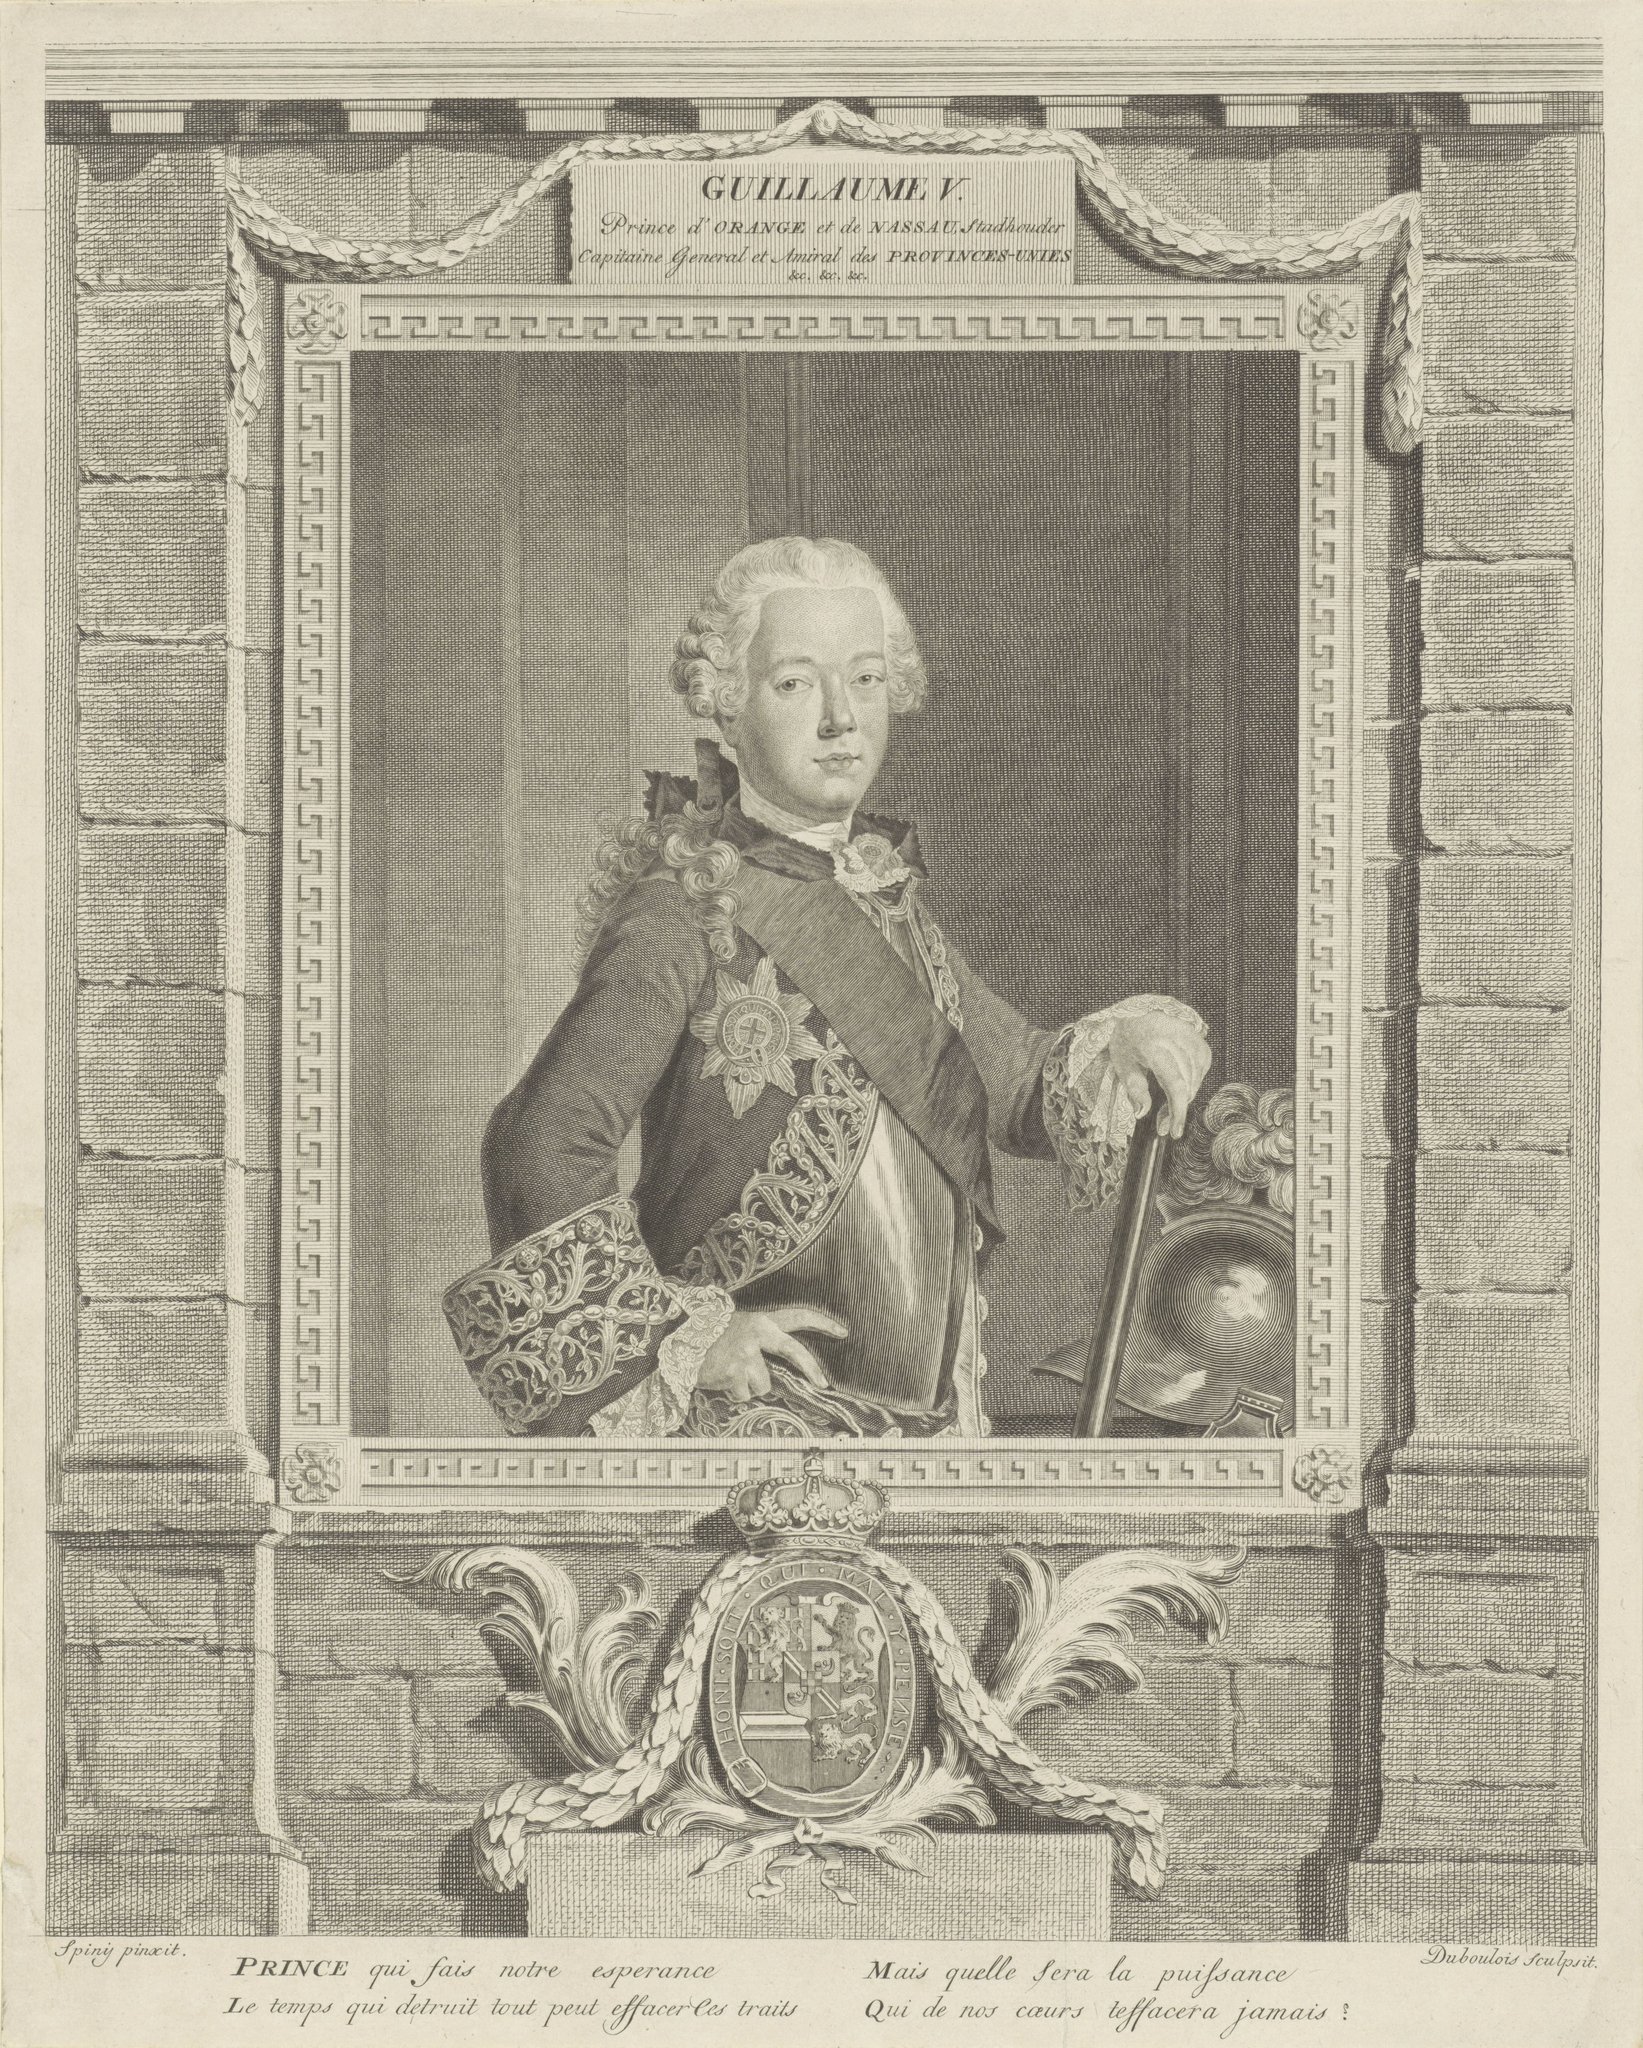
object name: print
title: Portret van Willem V, prins van Oranje-Nassau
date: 1765-1771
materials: paper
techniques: engraving, etching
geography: the hague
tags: william v (prince of orange), knighthood order (garter) - insignia of a knighthood order, e.g.: badge, chain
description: Portret van Willem V in een geornamenteerde rechthoek. In zijn linkerhand een commandostaf. In een kader zijn naam en titels. Midden onder zijn wapen met een kroon, gedecoreerd met de Kousenband en het devies van de Orde van de Kousenband. In de ondermarge twee kolommen met elk twee regels Franse tekst.